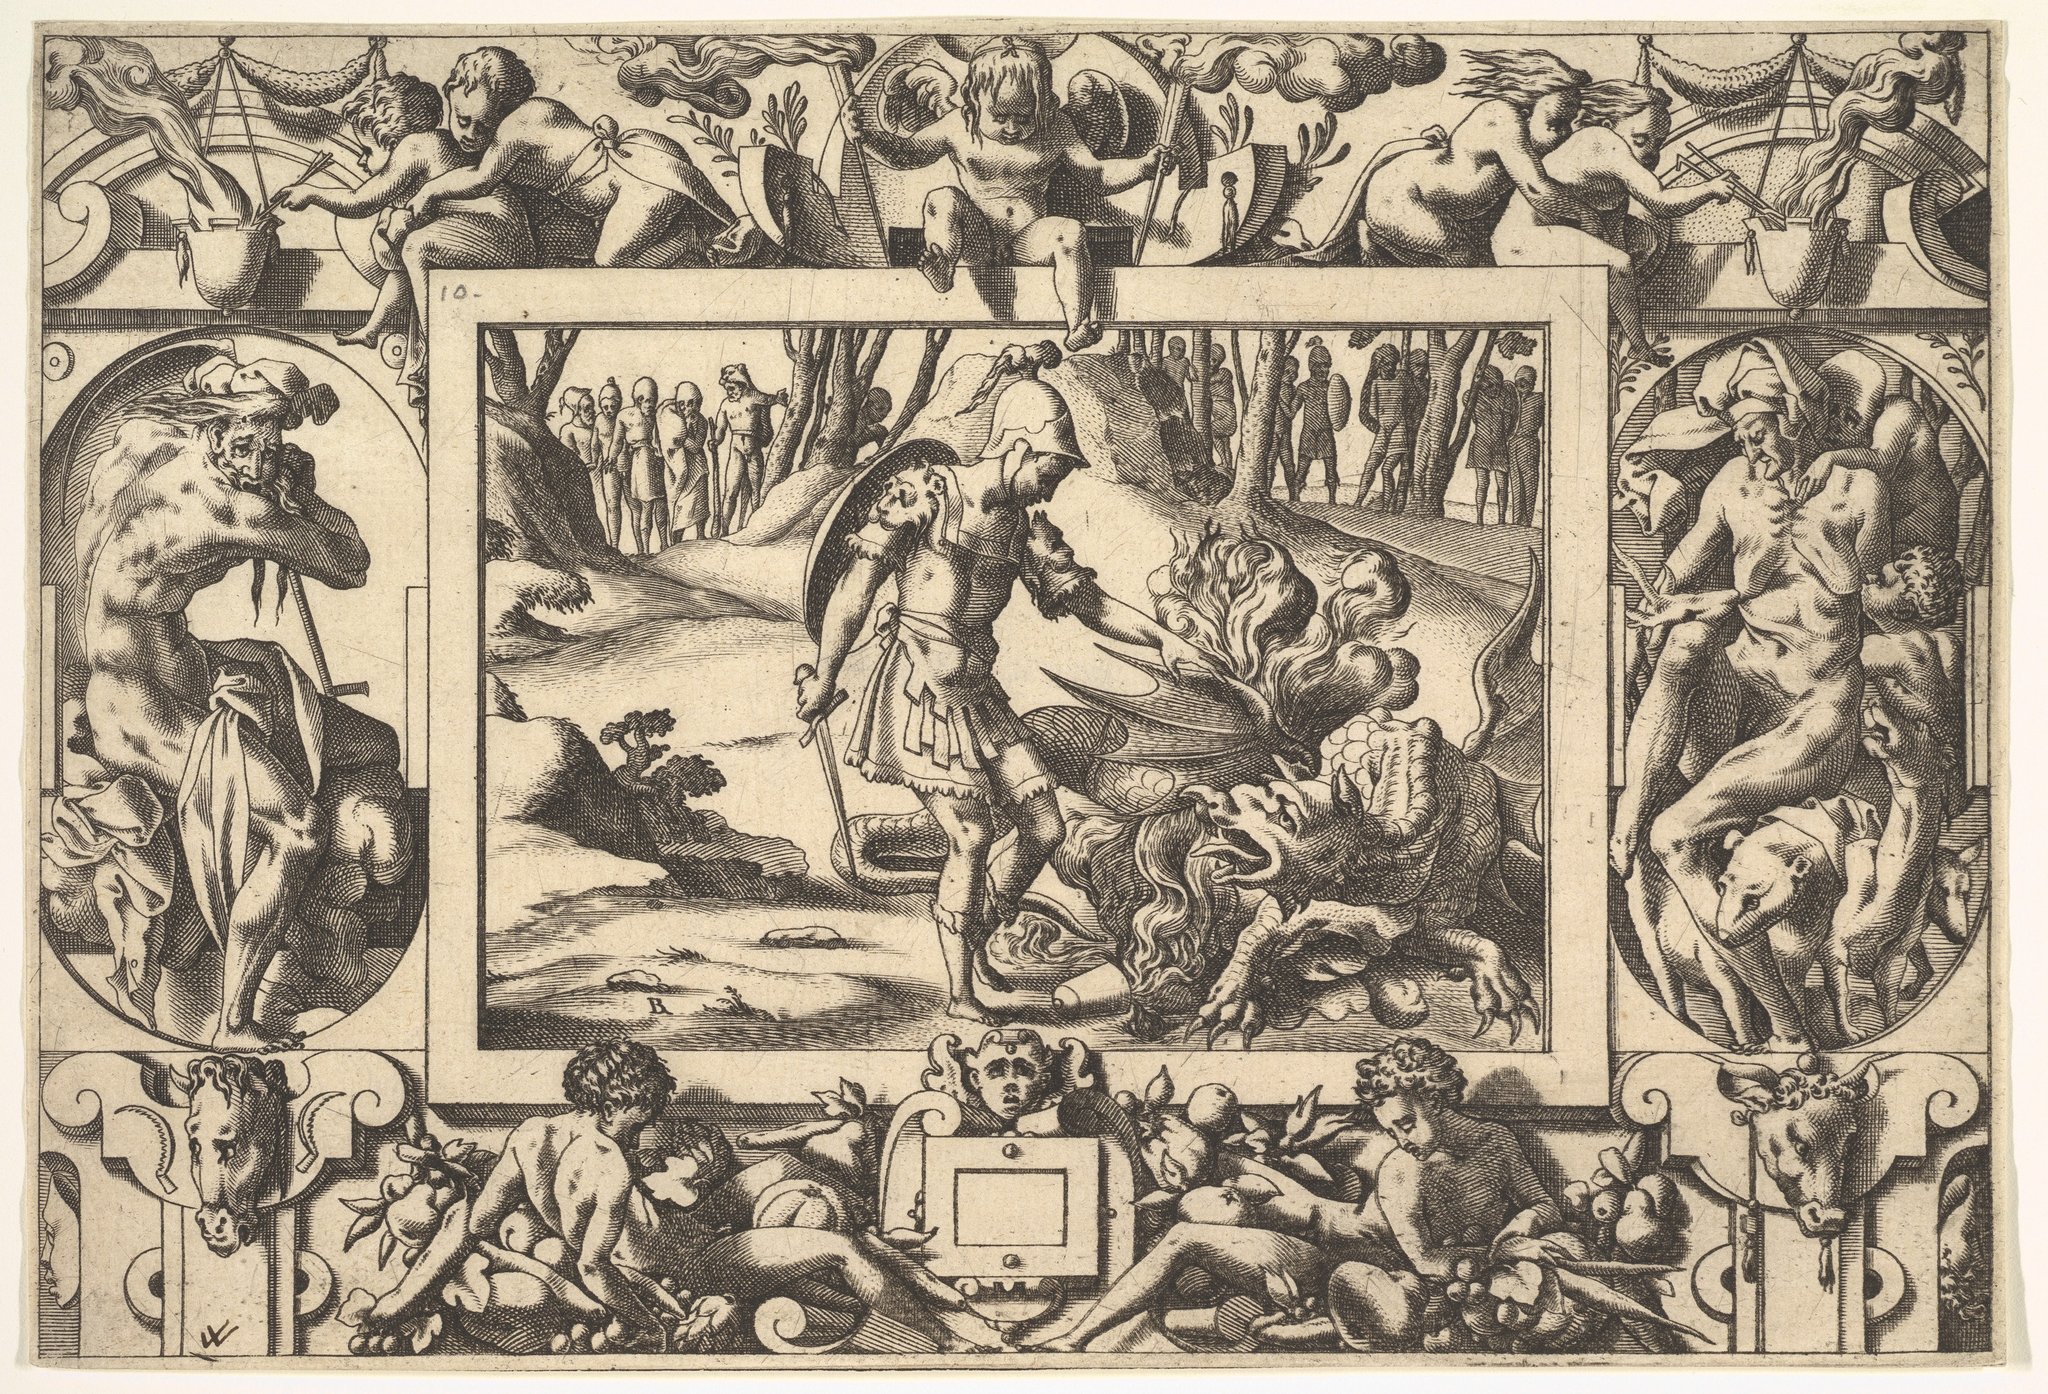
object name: print ornament architecture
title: Jason Confronts the Dragon Guarding the Golden Fleece (Par tels assauts Jason va travaillant le fier dragon de nuit et jour veillant...), from "Jason and the Golden Fleece"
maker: rené boyvin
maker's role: artist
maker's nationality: french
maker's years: 1525-1598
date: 1563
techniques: engraving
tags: jason,dragons,putti